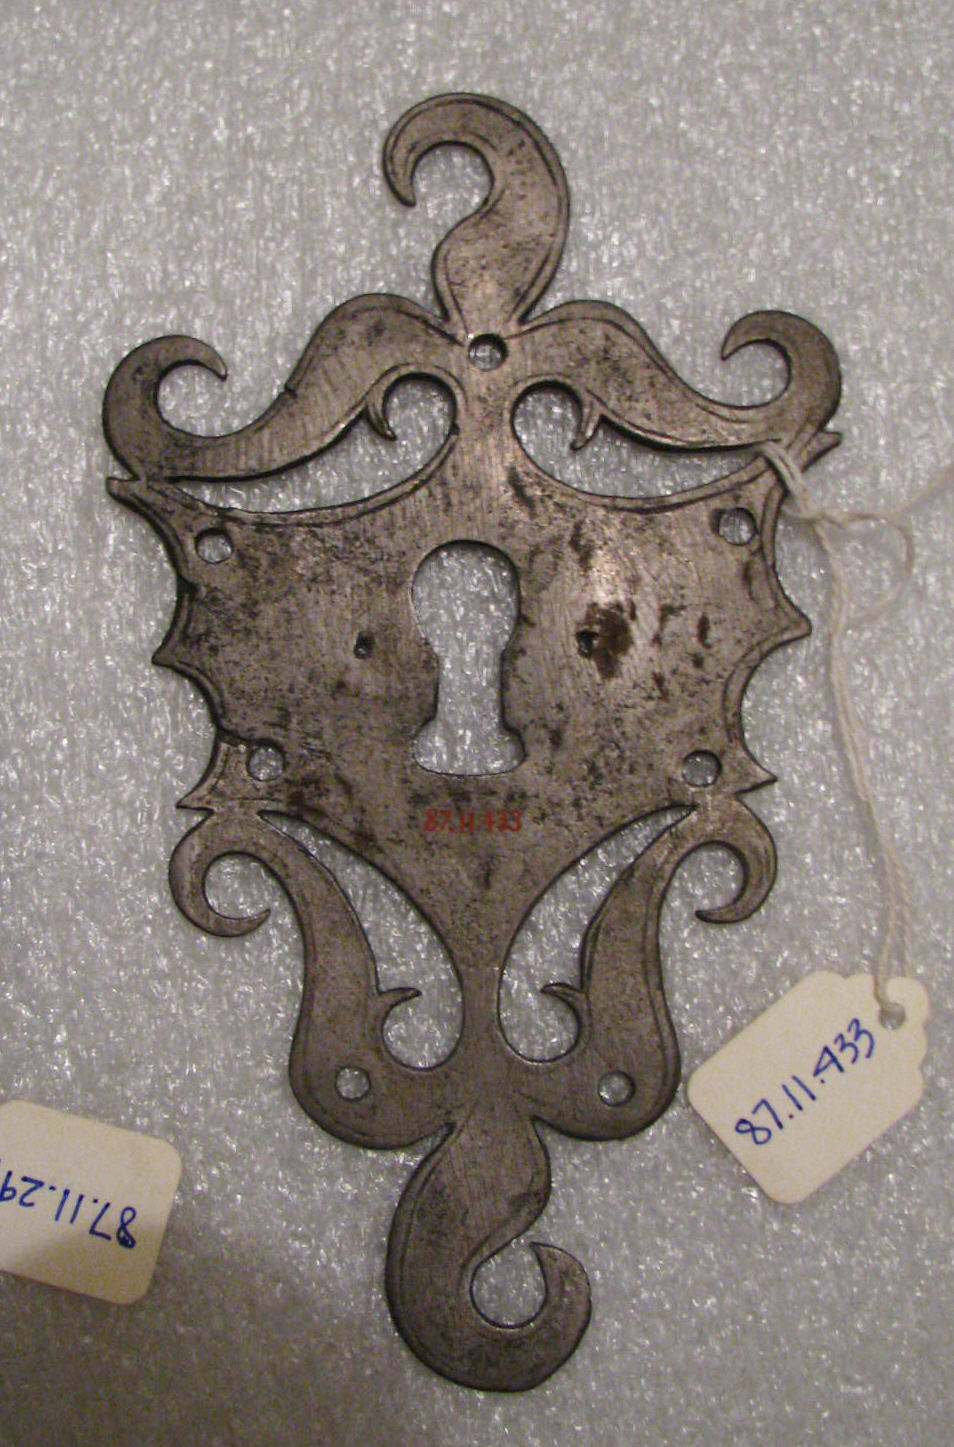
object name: escutcheon with lock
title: Escutcheon of lock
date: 1580-1600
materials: iron